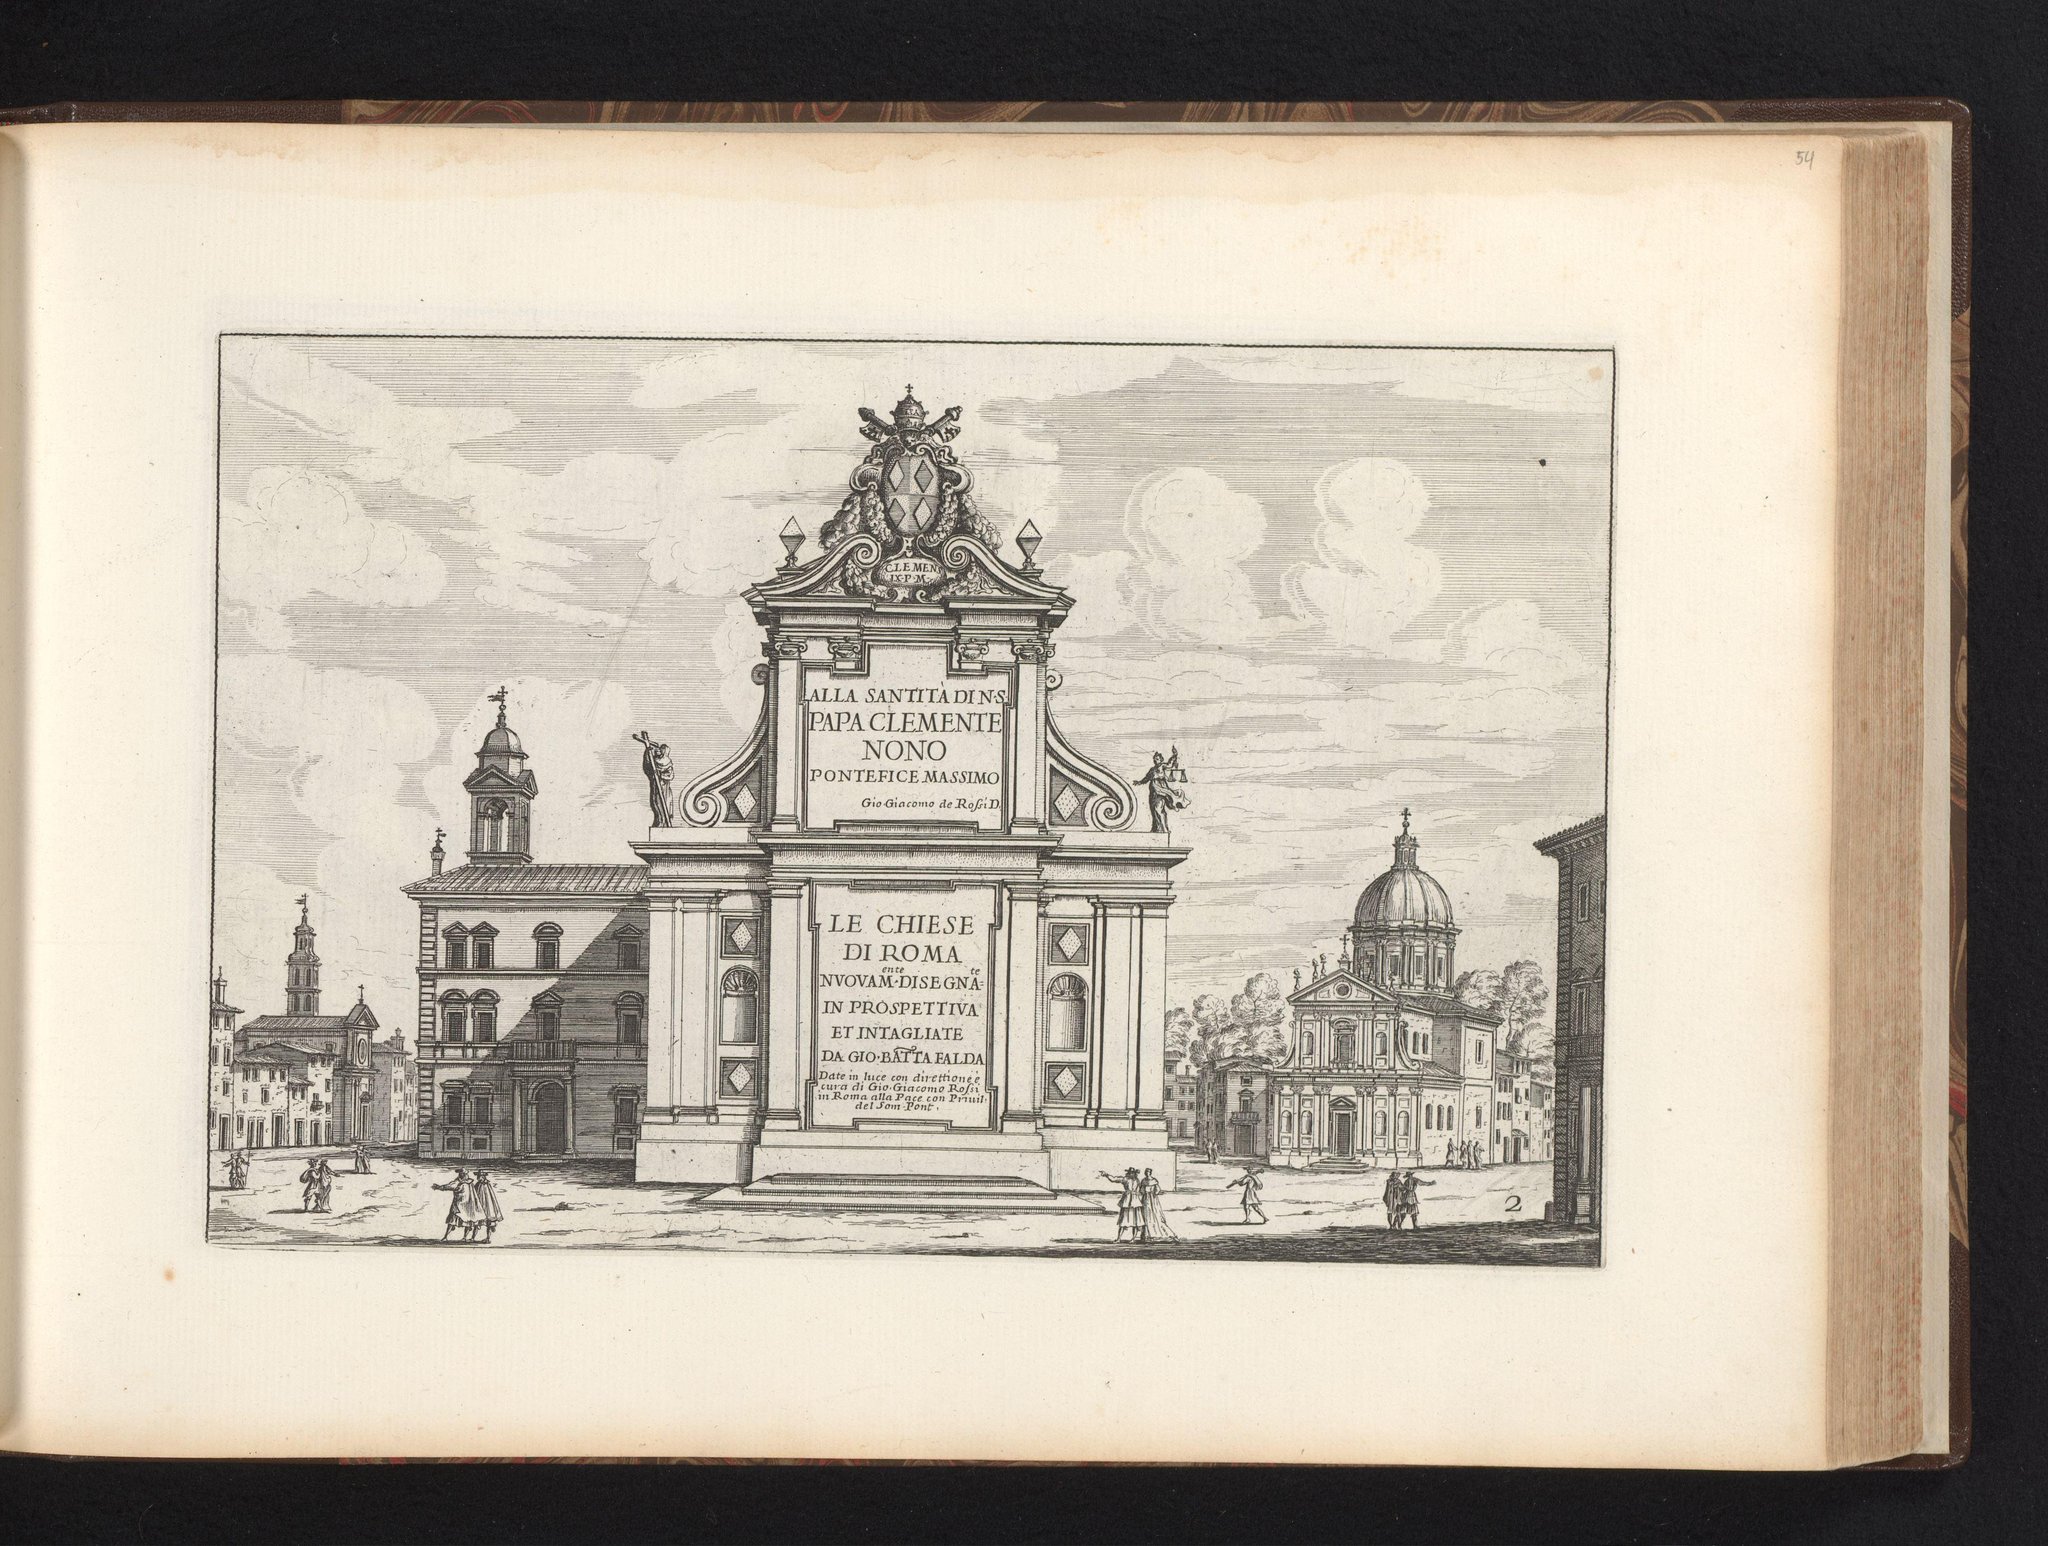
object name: album leaf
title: Moderne gebouwen te Rome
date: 1669-1670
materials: paper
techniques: etching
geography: rome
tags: church (exterior), parts of church exterior and annexes: façade, rome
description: Deze titelprent maakt deel uit van een reeks van 38 prenten met voorstellingen van kerken in Rome. Samen met vier andere reeksen vormt het de grote reeks: 'Il nuovo teatro di Roma moderna'.